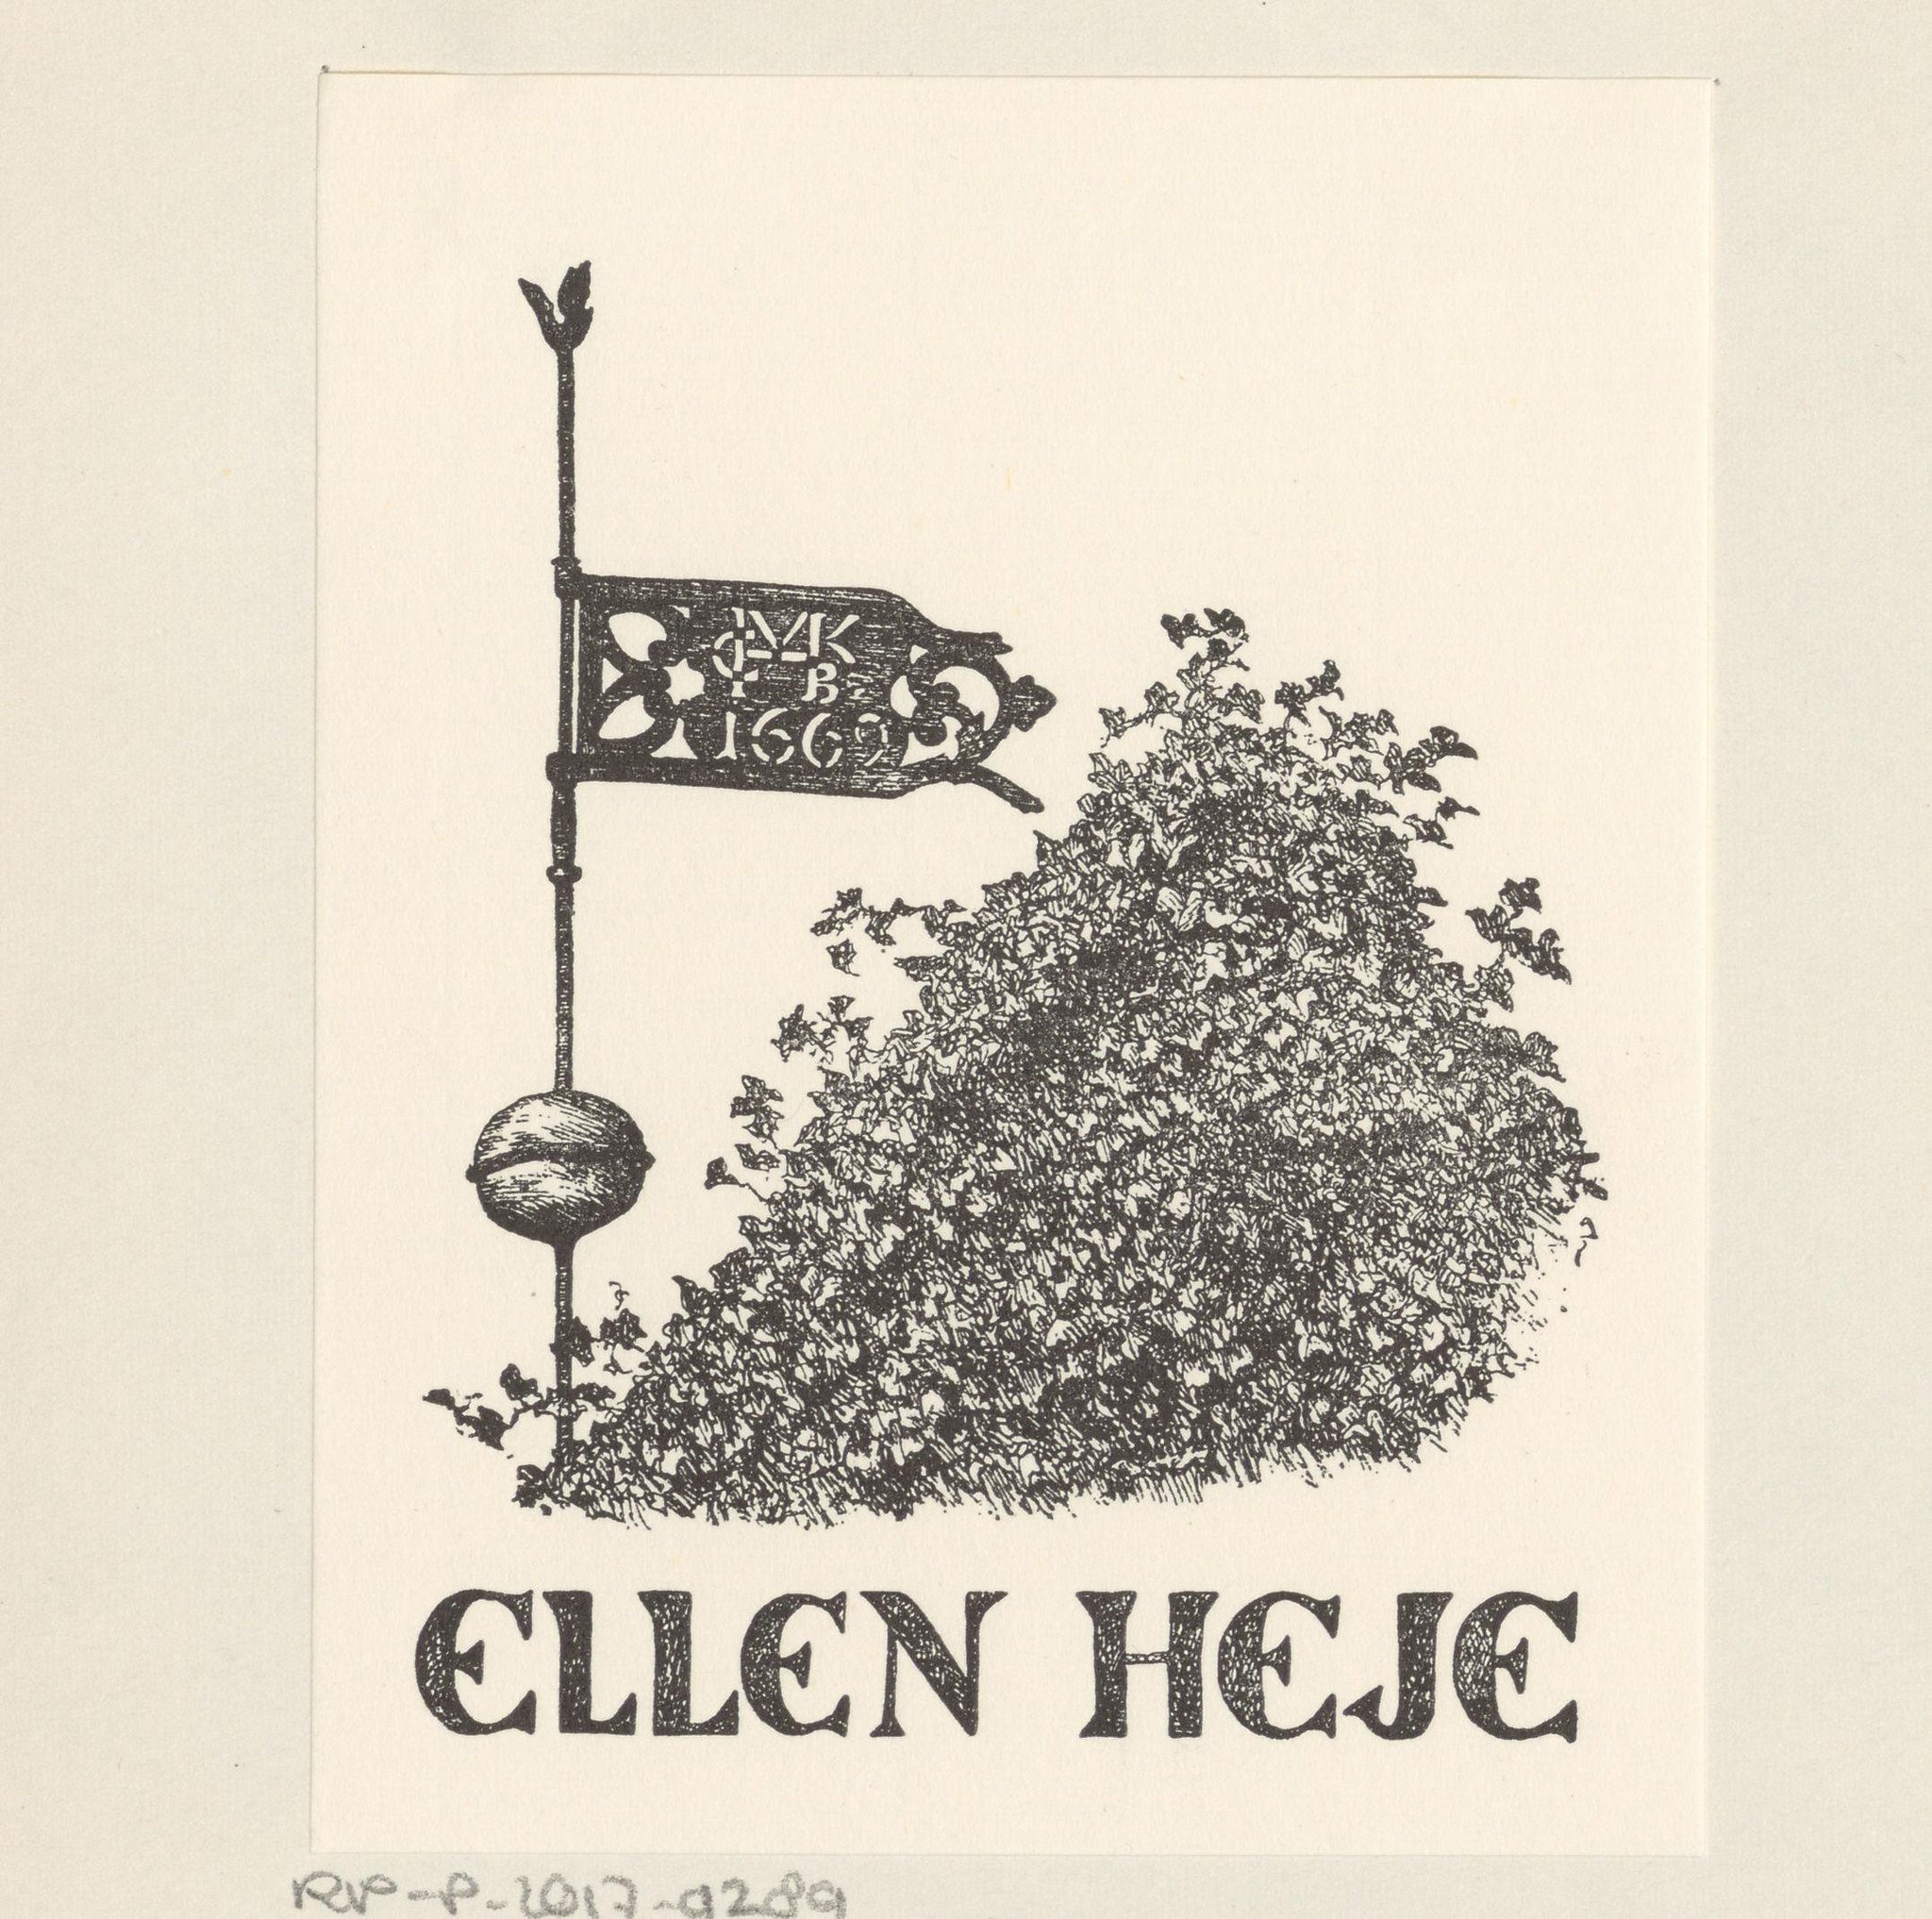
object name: bookplate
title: Ex libris van Ellen Heje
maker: Anonymous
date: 1900-1999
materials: paper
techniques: printing block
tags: banner, standard (as symbol of the state, etc.), plants and herbs: ivy